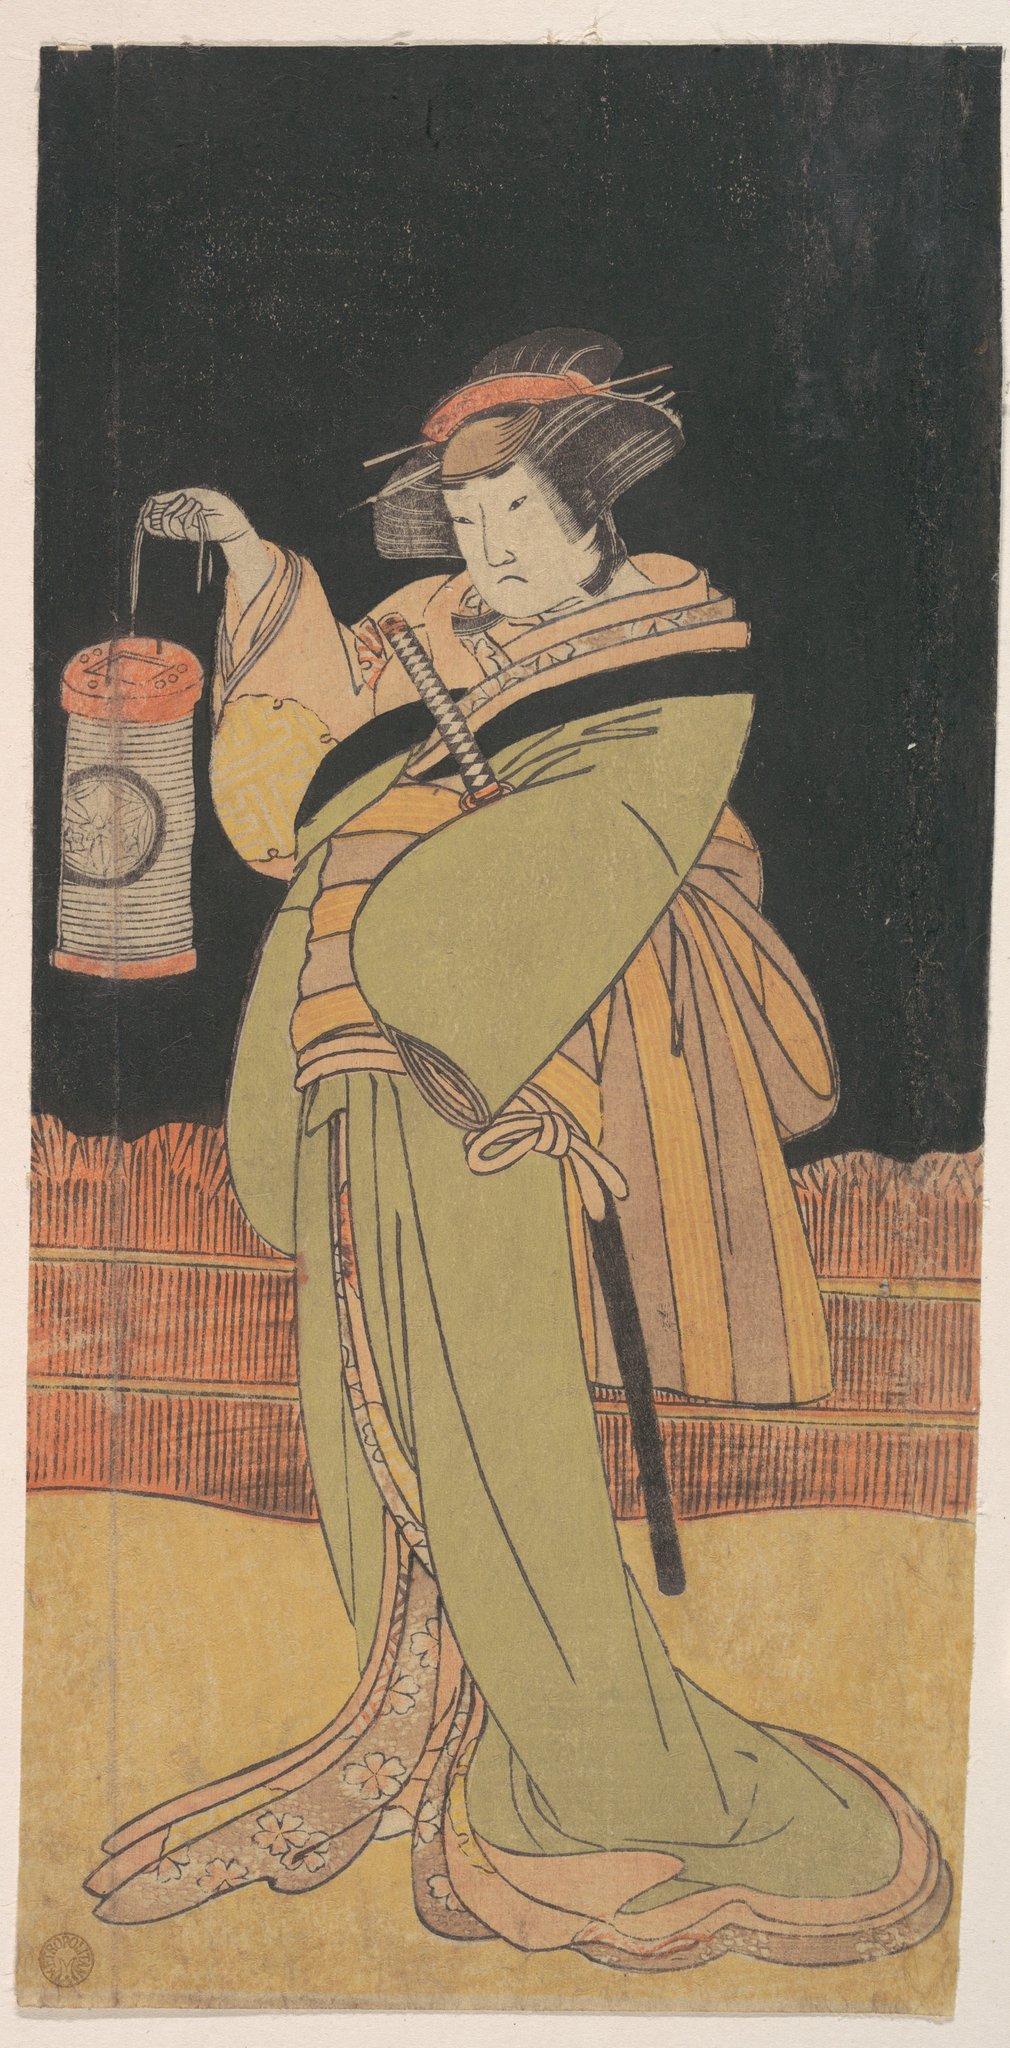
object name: woodblock print nishiki e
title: The Second Yamashita Kinsaku as a Woman Standing at Night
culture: japanese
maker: katsukawa shunshō 勝川春章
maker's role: artist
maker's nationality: japanese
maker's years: 1726-1792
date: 1779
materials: ink, paper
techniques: nishiki e, woodblock print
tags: night,actors